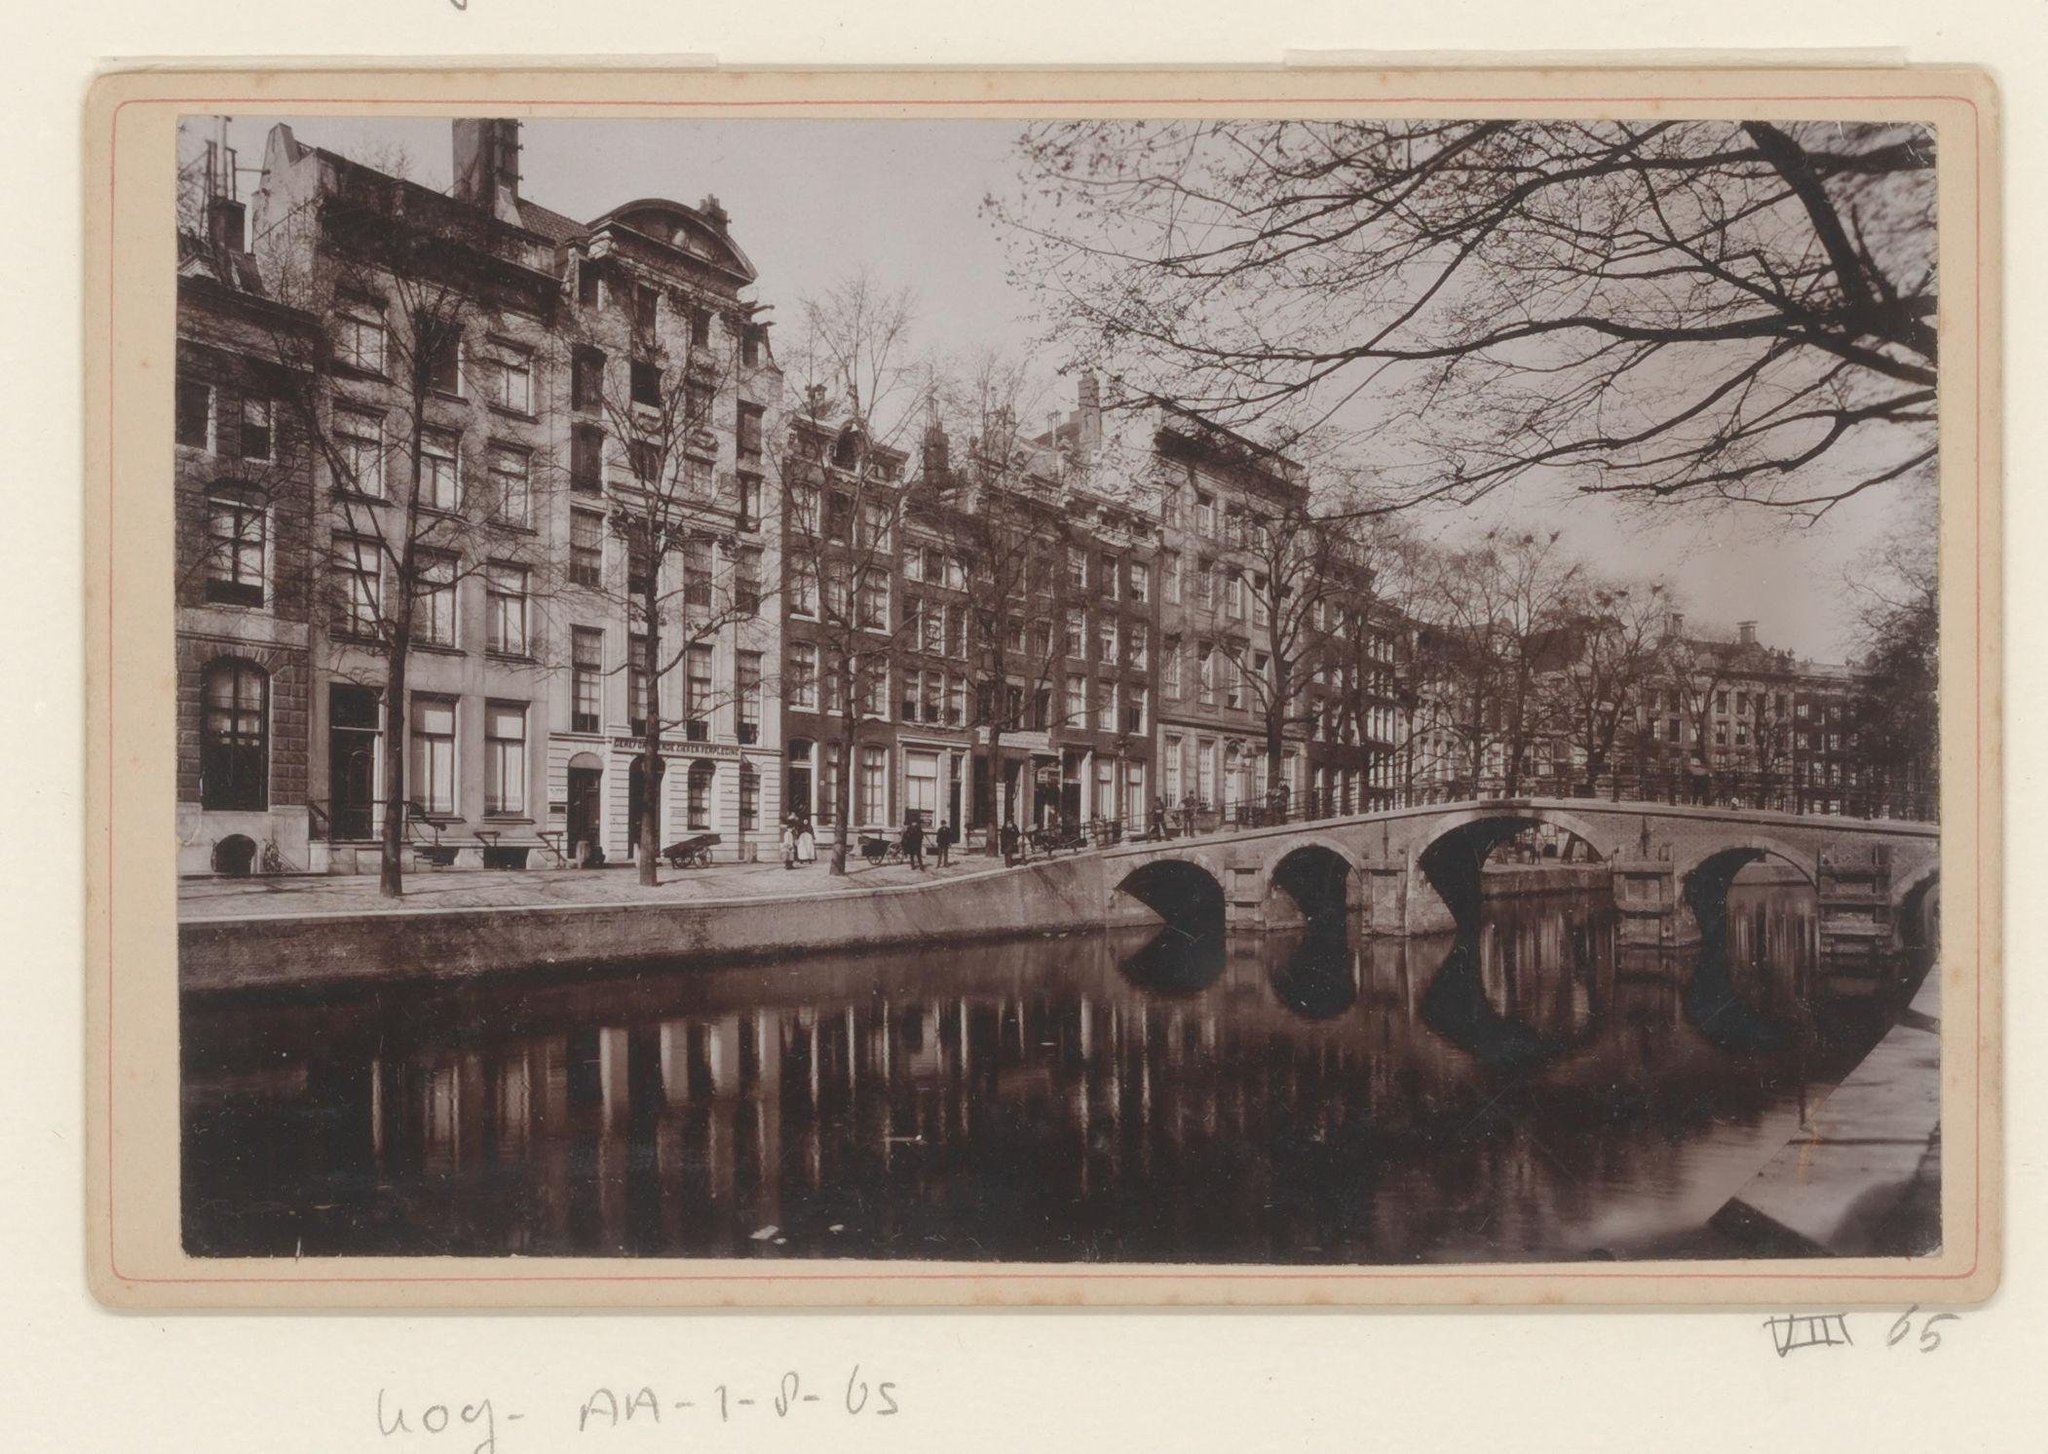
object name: cabinet photograph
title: Gezicht op de Herengracht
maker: Anonymous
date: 1875-1896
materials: paper, cardboard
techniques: collodion silver print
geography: amsterdam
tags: city-view in general; 'veduta', canal, the usual house or row of houses, bridge in city across river, canal, etc.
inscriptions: stamp: ‘Gebr. Douwes / Atelier Grimburgwal 15 / Amsterdam’, collector's mark: ‘8/65’ Lugt 1641b, inscription: ‘Heerengracht a/d Warmoesgracht v/d / afbraak.’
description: Onderwerpsrubriek binnen de Atlas Amsterdam: Haarlemmerplein, Halvemaansteeg, Handboogstraat, Handelskade, Haringpakkerij, Hartenstraat, Hasseltsteeg (Dirk van), Heerengracht.